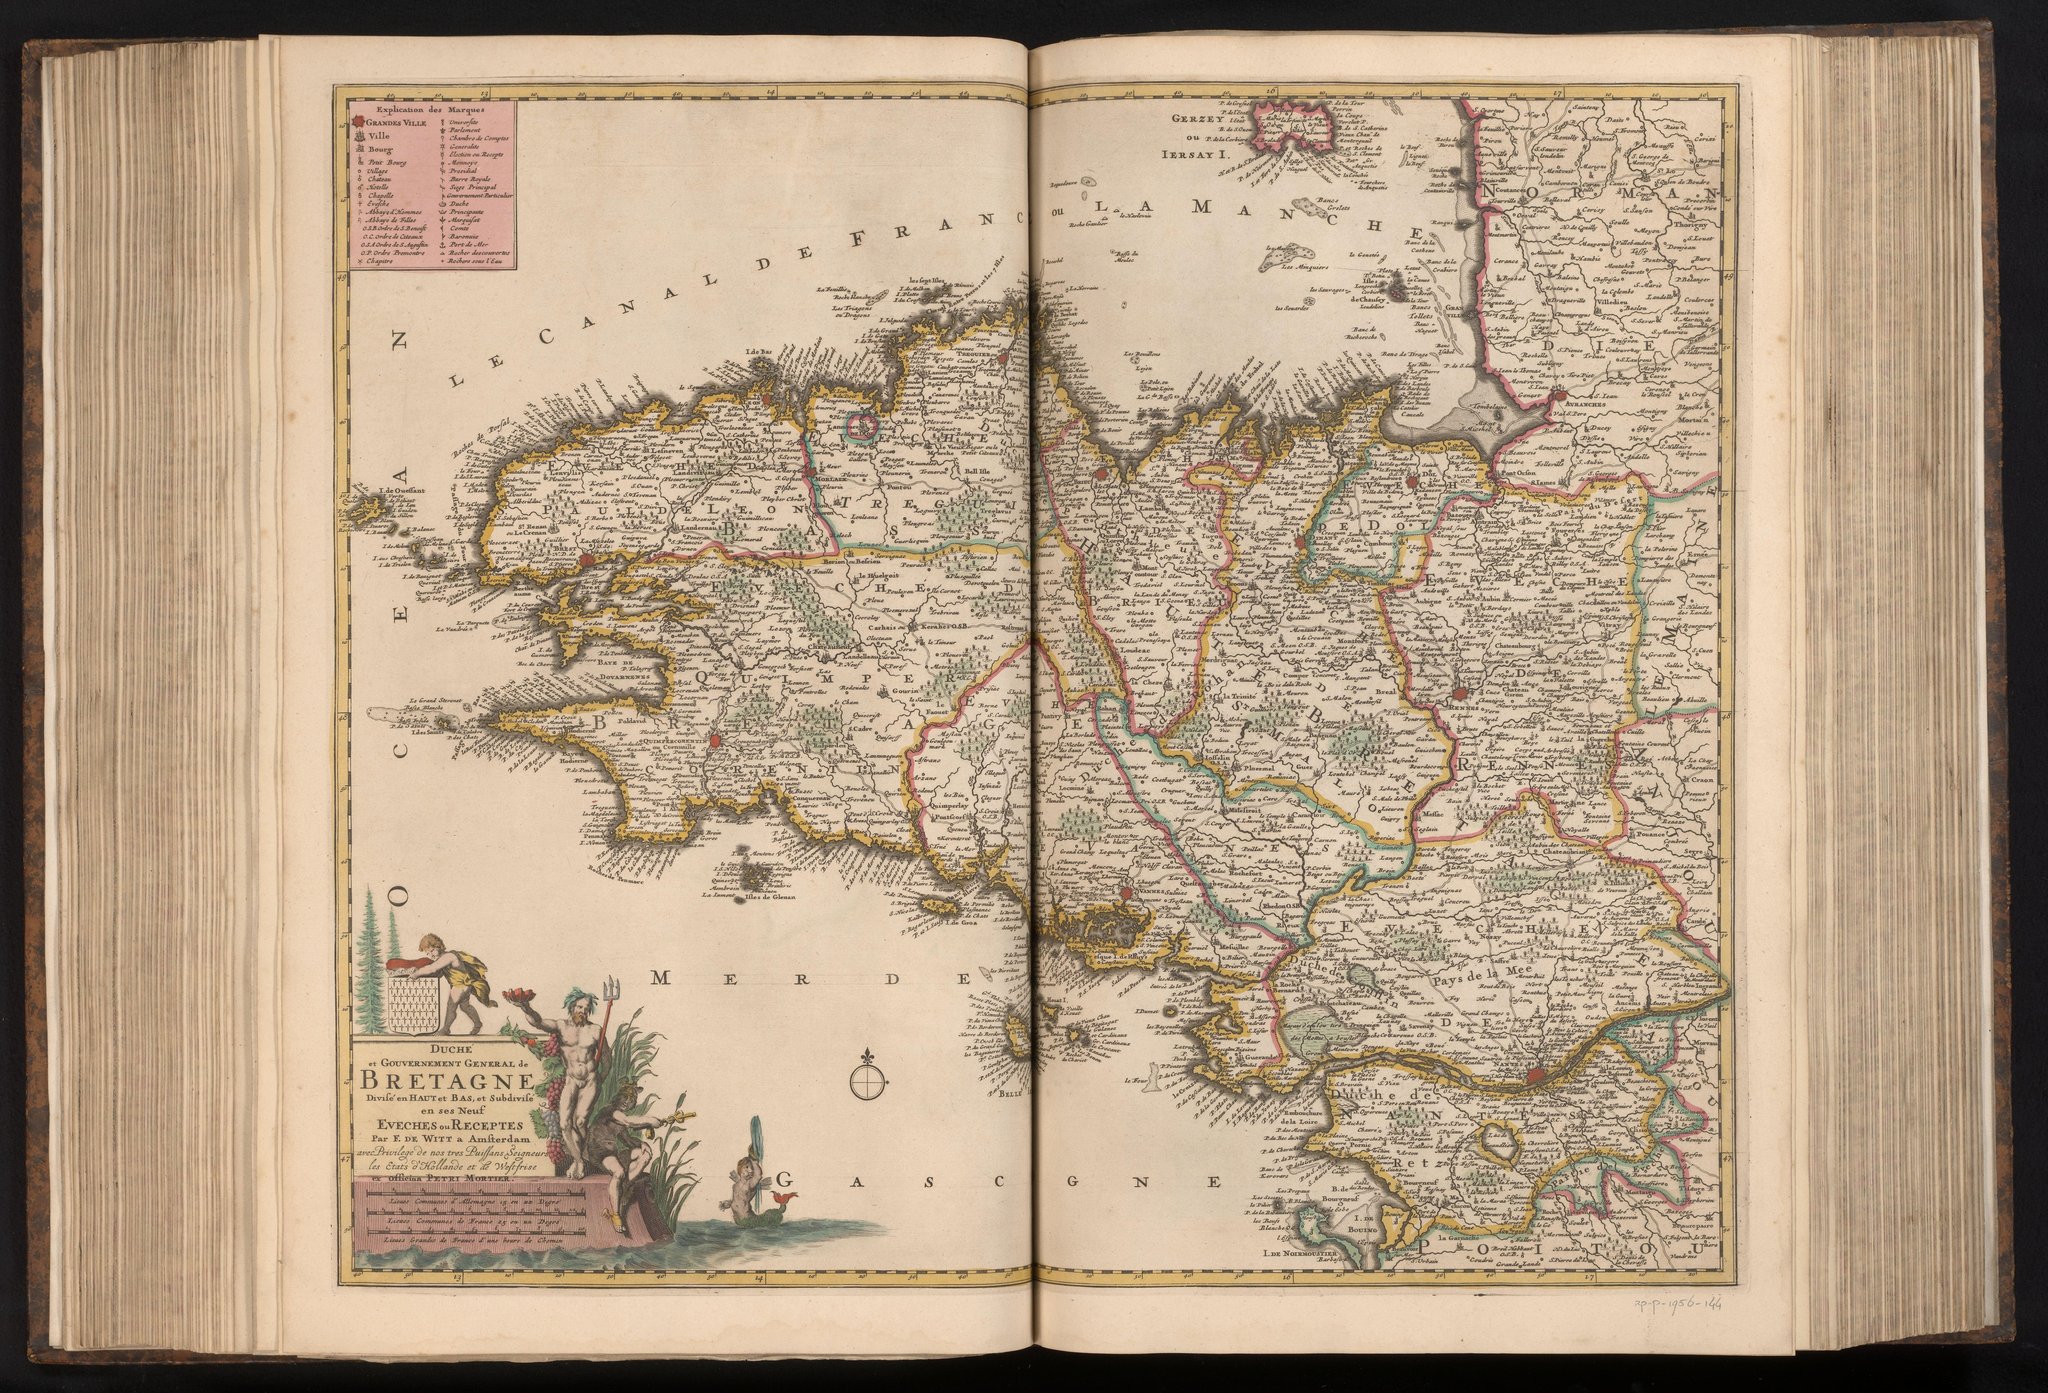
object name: album leaf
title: Duché et gouvernement general de Bretagne divisé en haut et bas, et subdivisé en ses neuf eveches ou receptes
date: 1671-1701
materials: paper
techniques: engraving, etching, hand coloring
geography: amsterdam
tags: maps of separate countries or regions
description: Deze prent maakt deel uit van een album.